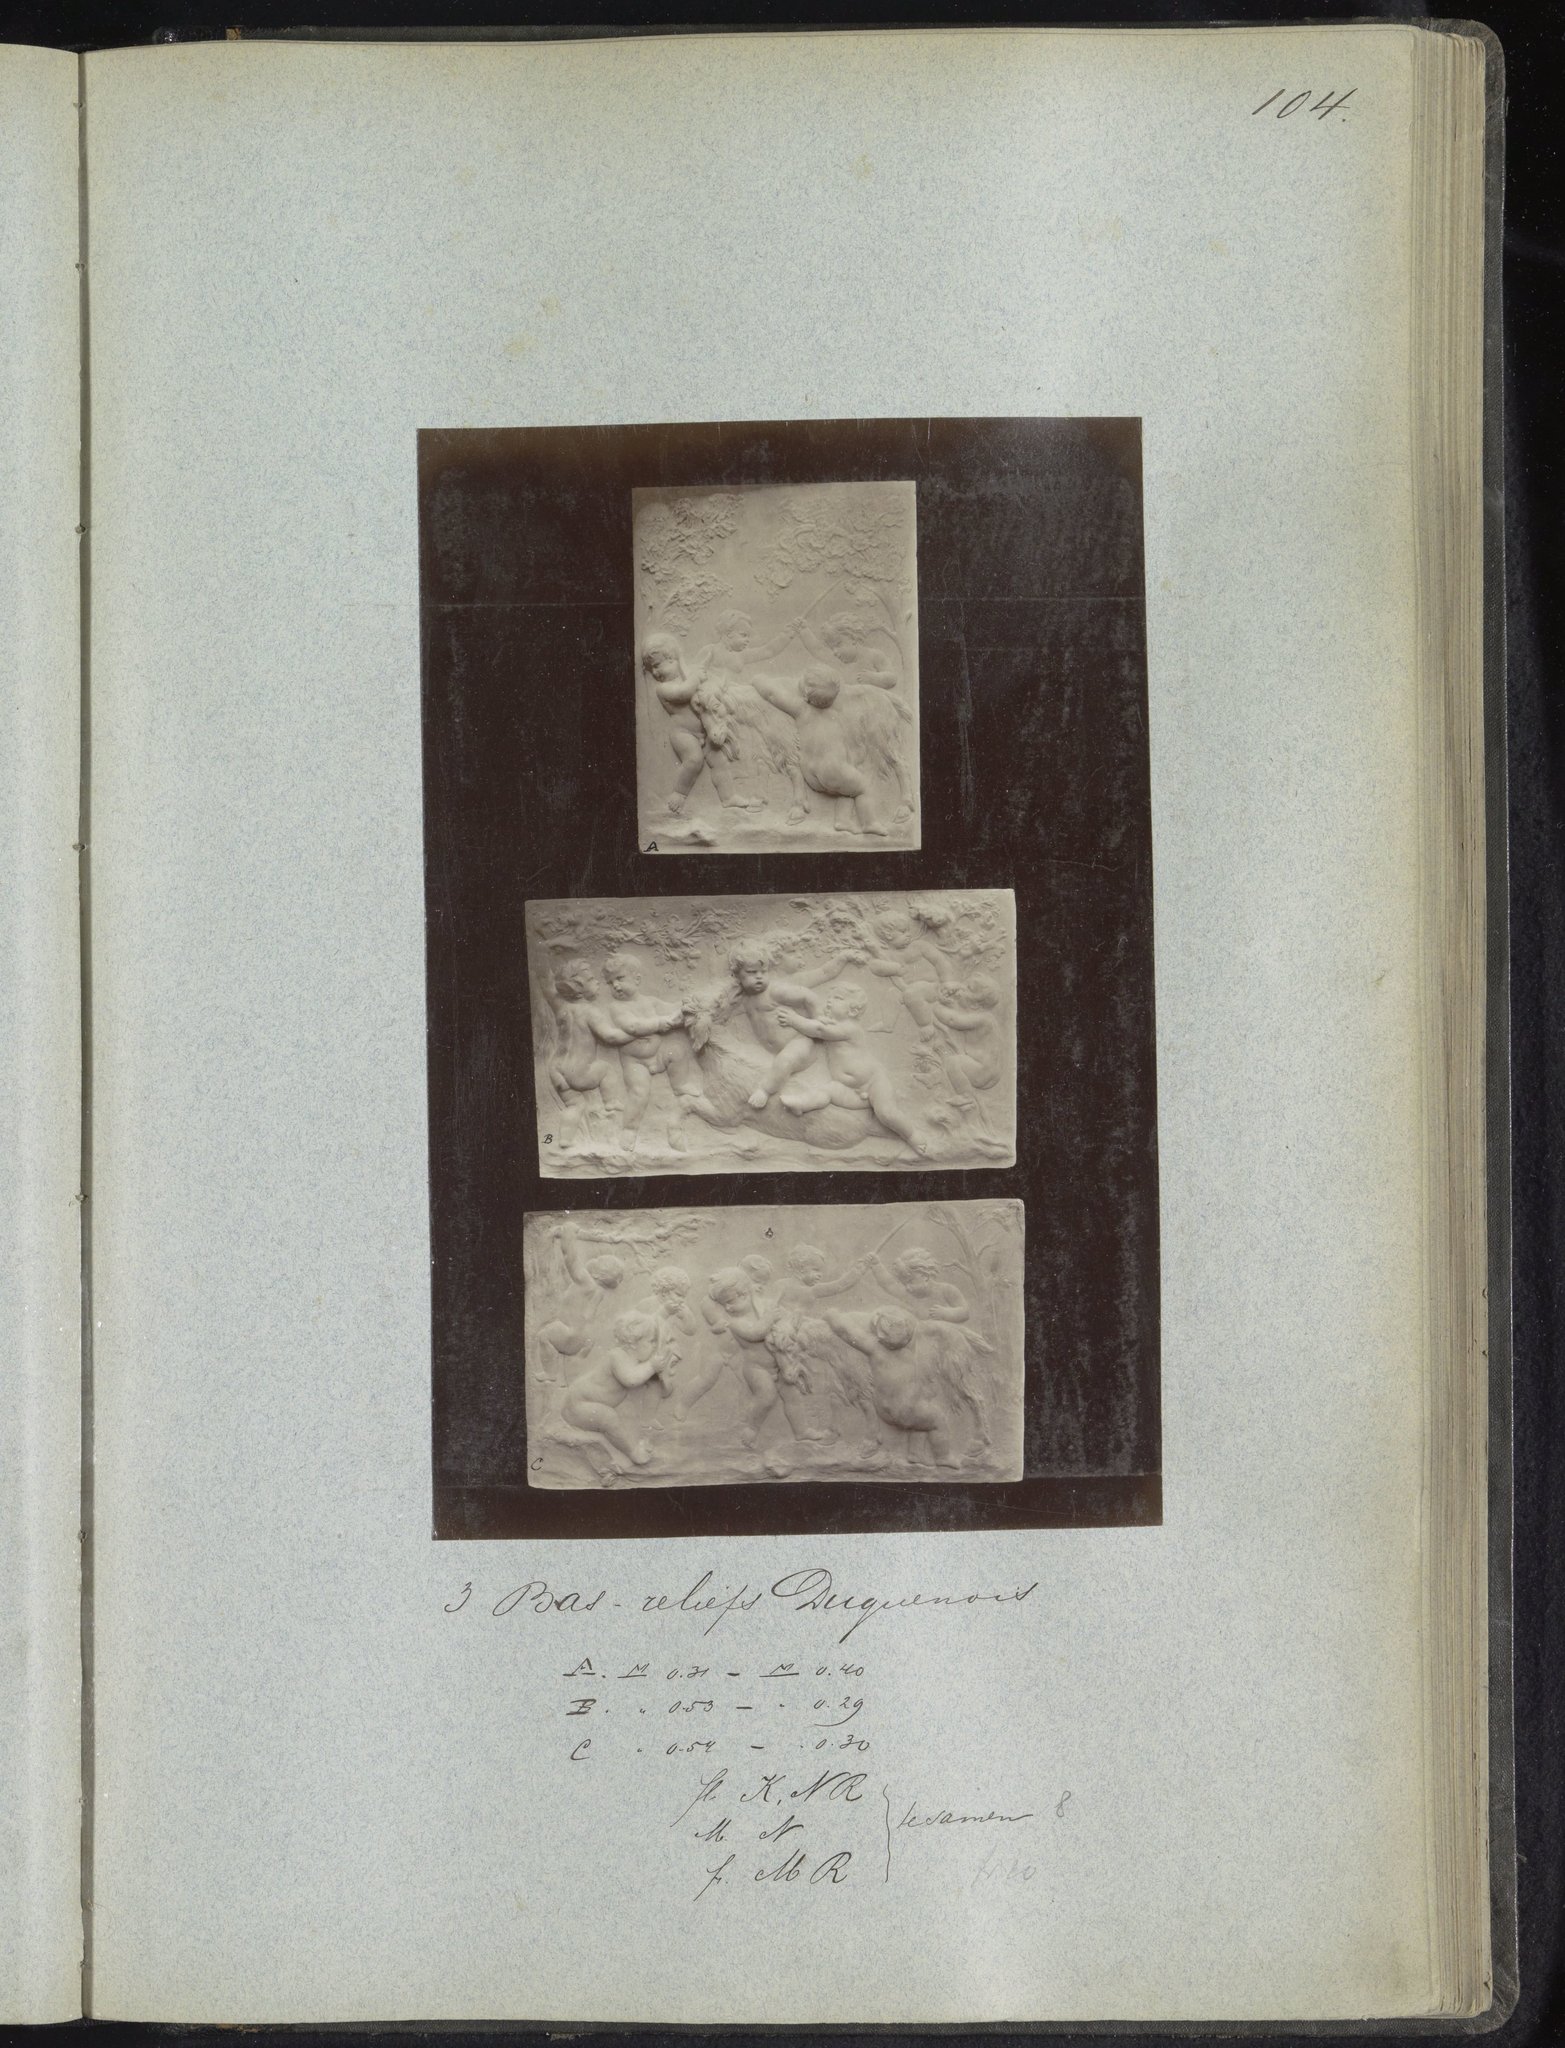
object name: photograph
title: Drie gipsen afgietsels van panelen met bas-reliëfs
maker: Anonymous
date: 1875-1900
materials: paper, photographic support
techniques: albumen print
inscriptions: annotation: ‘3 Bas-reliëfs Duquenois’, annotation, annotation: ‘A. M 0.31-M 0.40 / B. M 0.53-0.29 / C. 0.54-0.30’, annotation